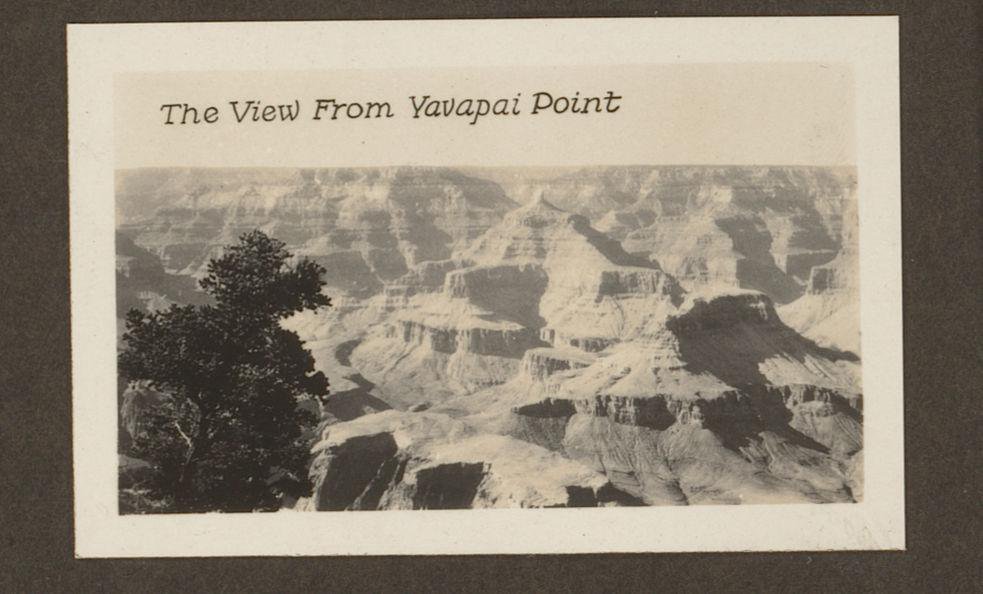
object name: photograph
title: The View Point Yavapai Point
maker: Anonymous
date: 1928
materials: photographic support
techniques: gelatin silver print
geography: grand canyon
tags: ravine, chasm, abyss, canyon, mountains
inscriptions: annotation: ‘Grand Canyon’